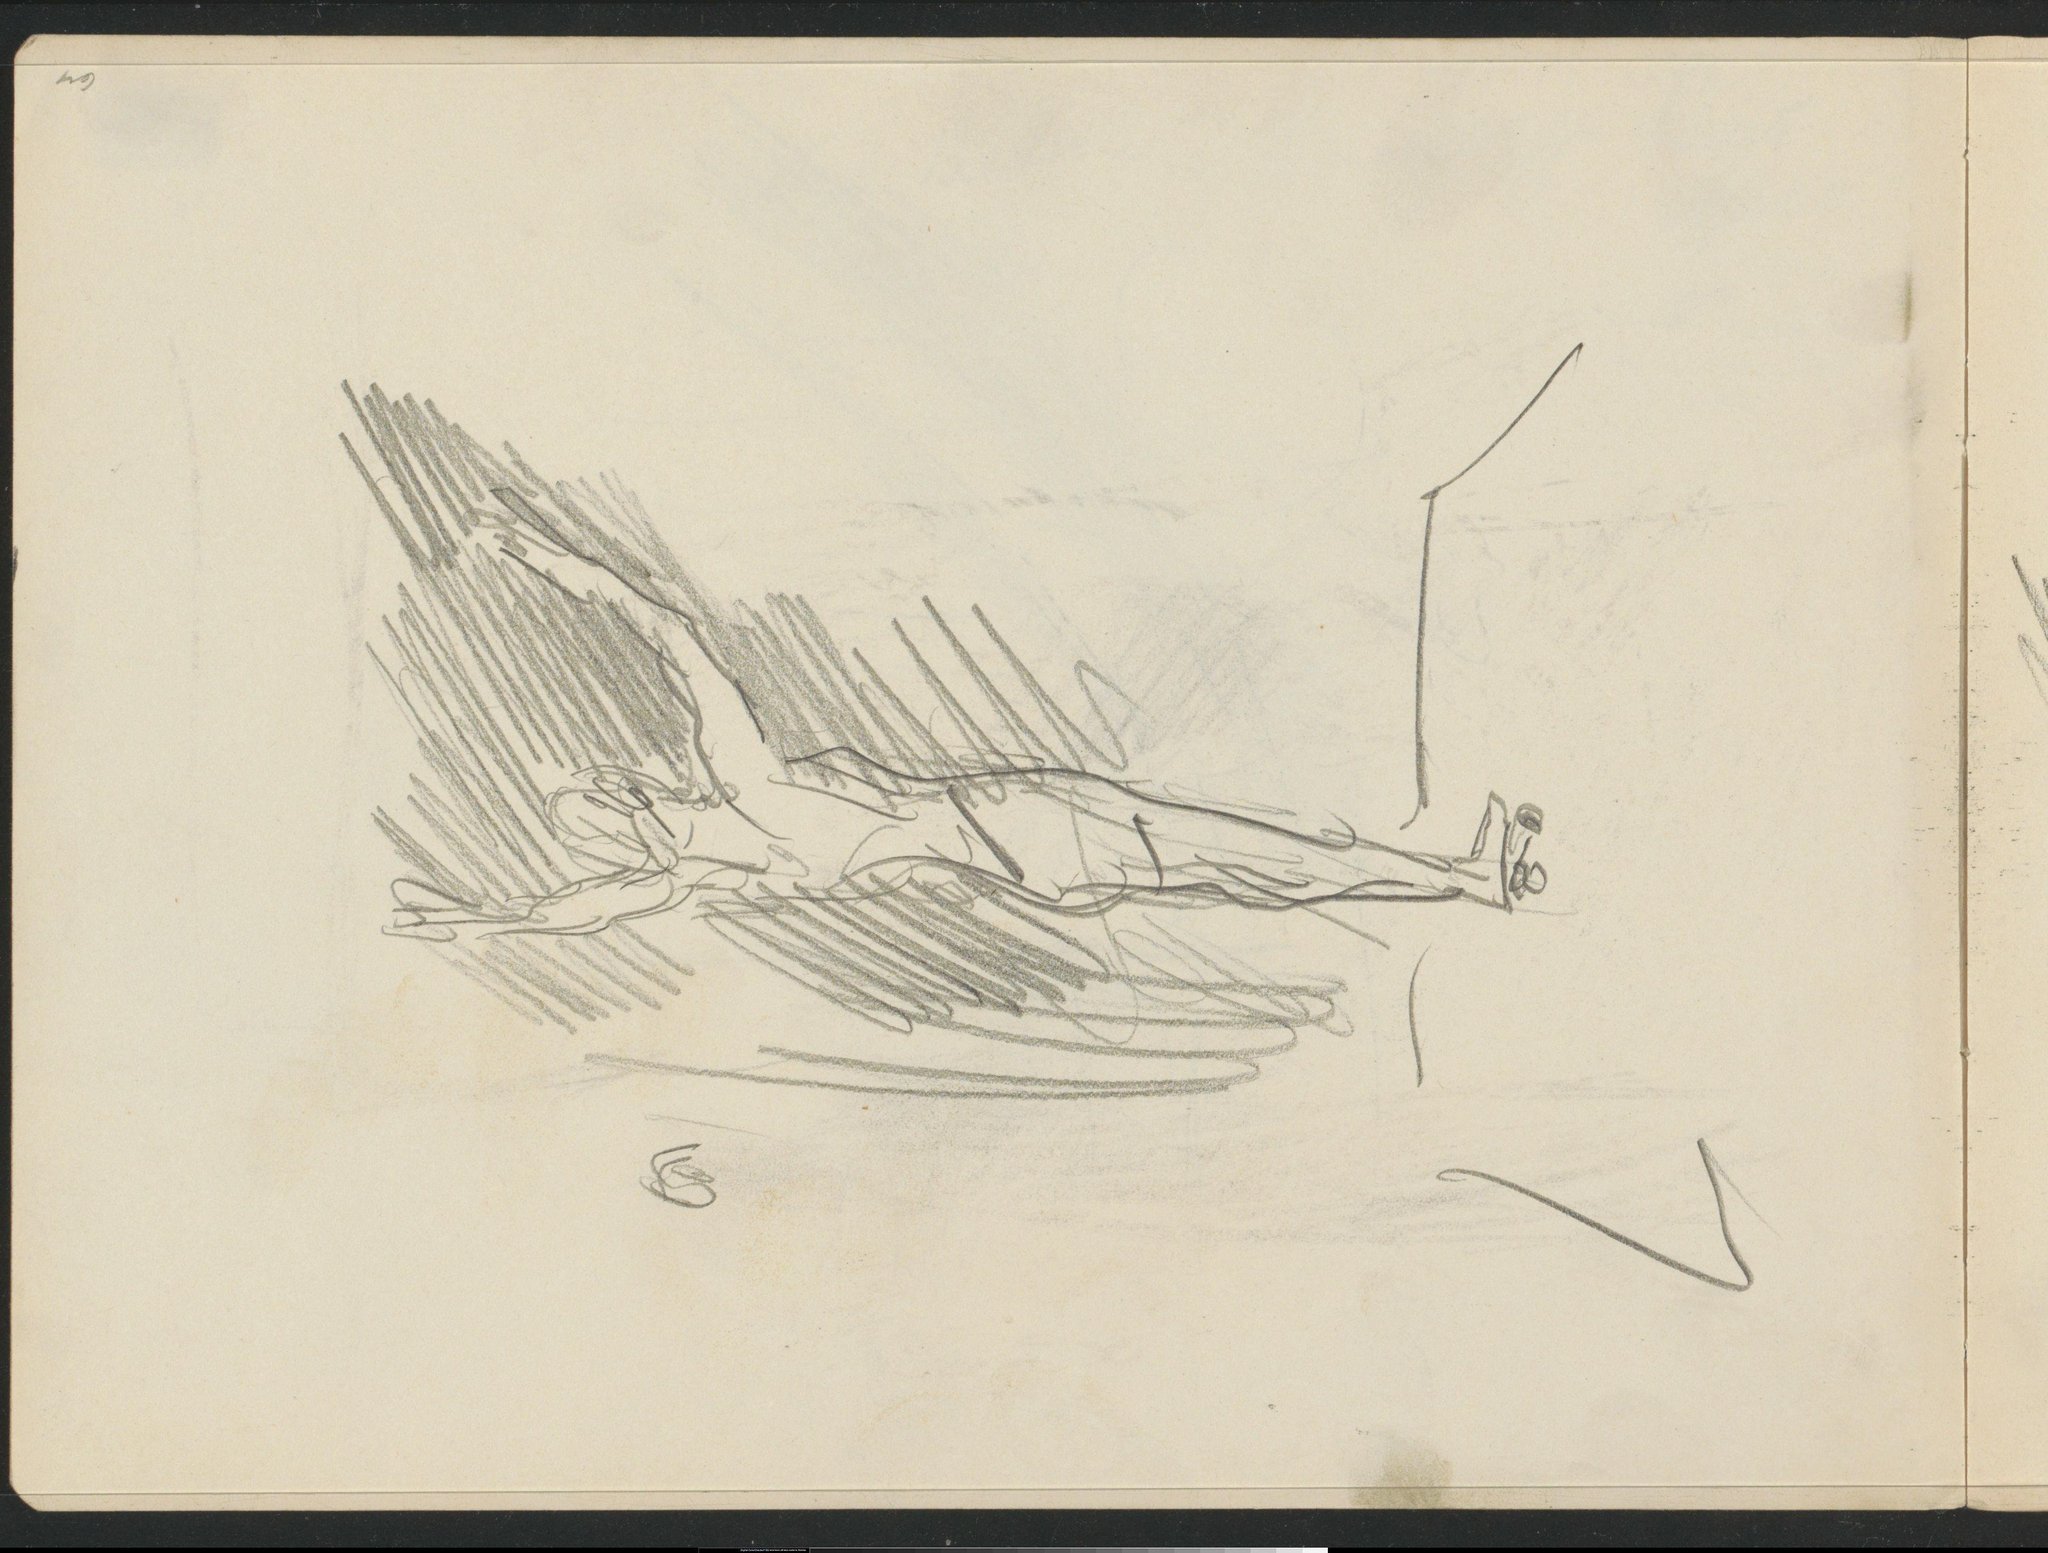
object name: sketchbook leaf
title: Staande vrouw met gestrekte armen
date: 1915-1934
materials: paper, pencil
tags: acrobat ~ circus, adult woman (+ standing)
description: Ze staat mogelijk op wieltjes en kan een acrobate zijn. Blad 1 verso uit schetsboek XVI met 32 bladen.